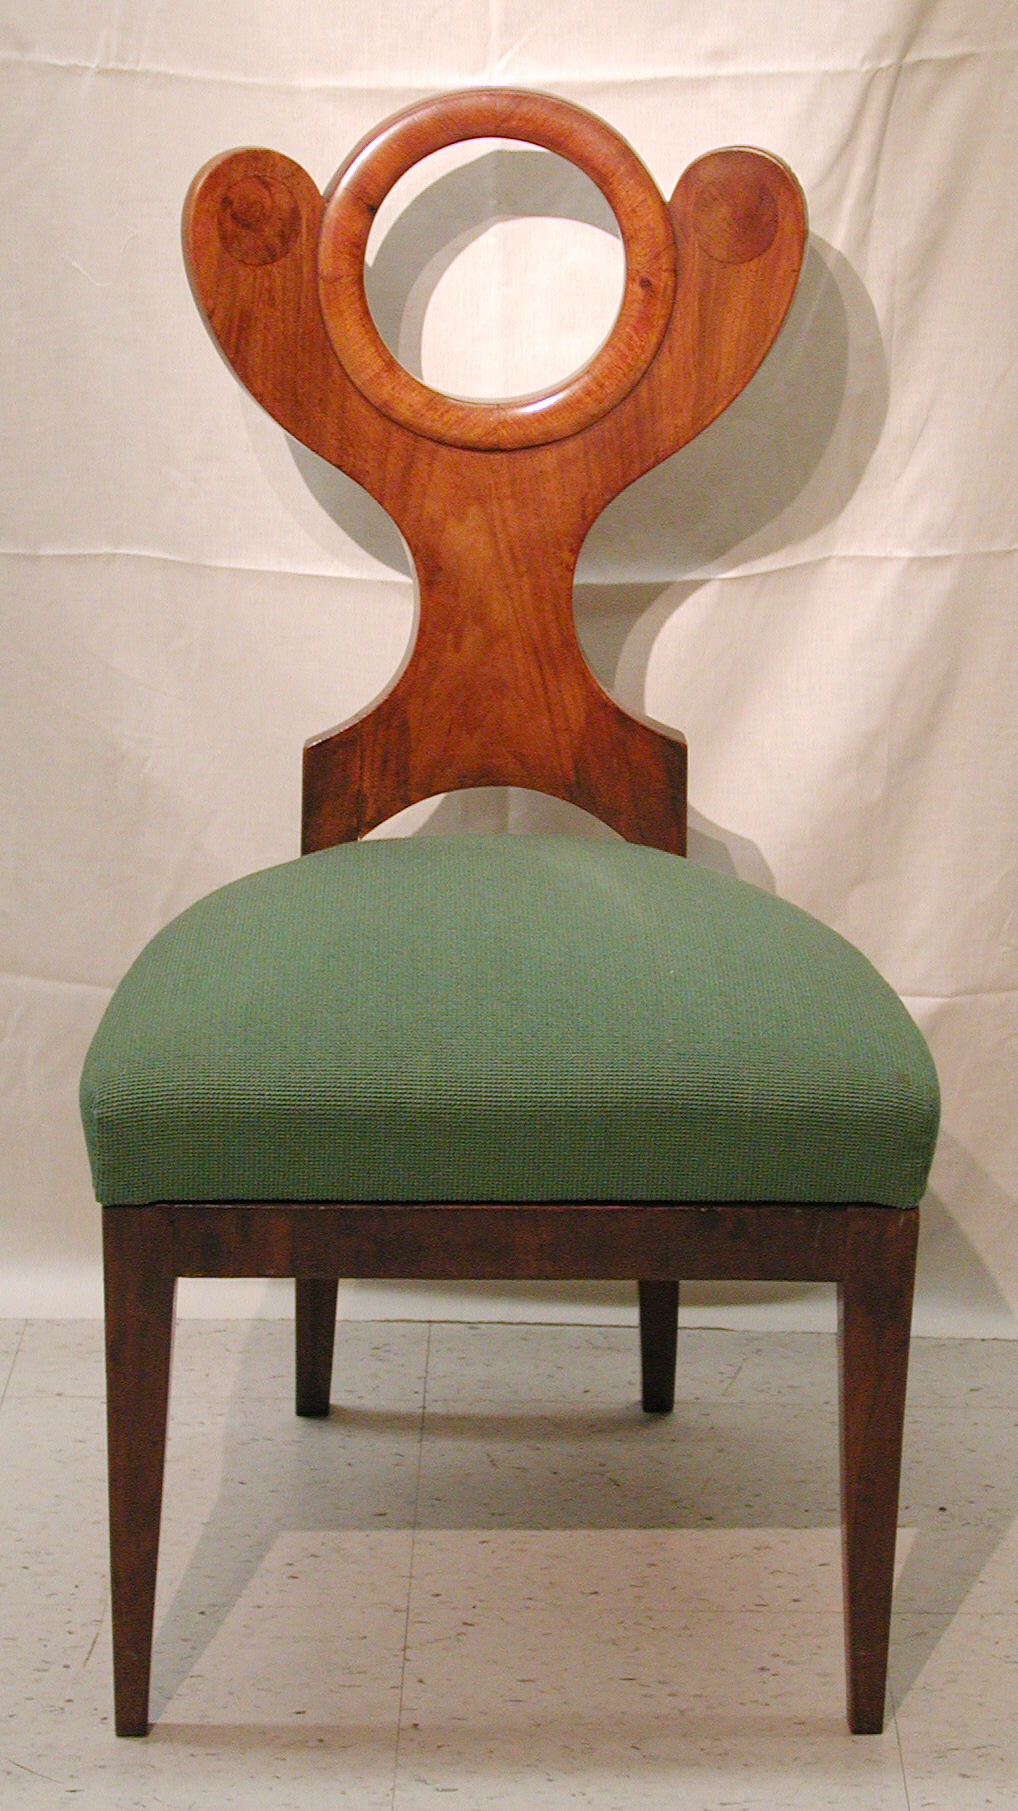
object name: side chair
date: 1820-1830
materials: wood, textile, cotton, metal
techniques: enamel, veneering